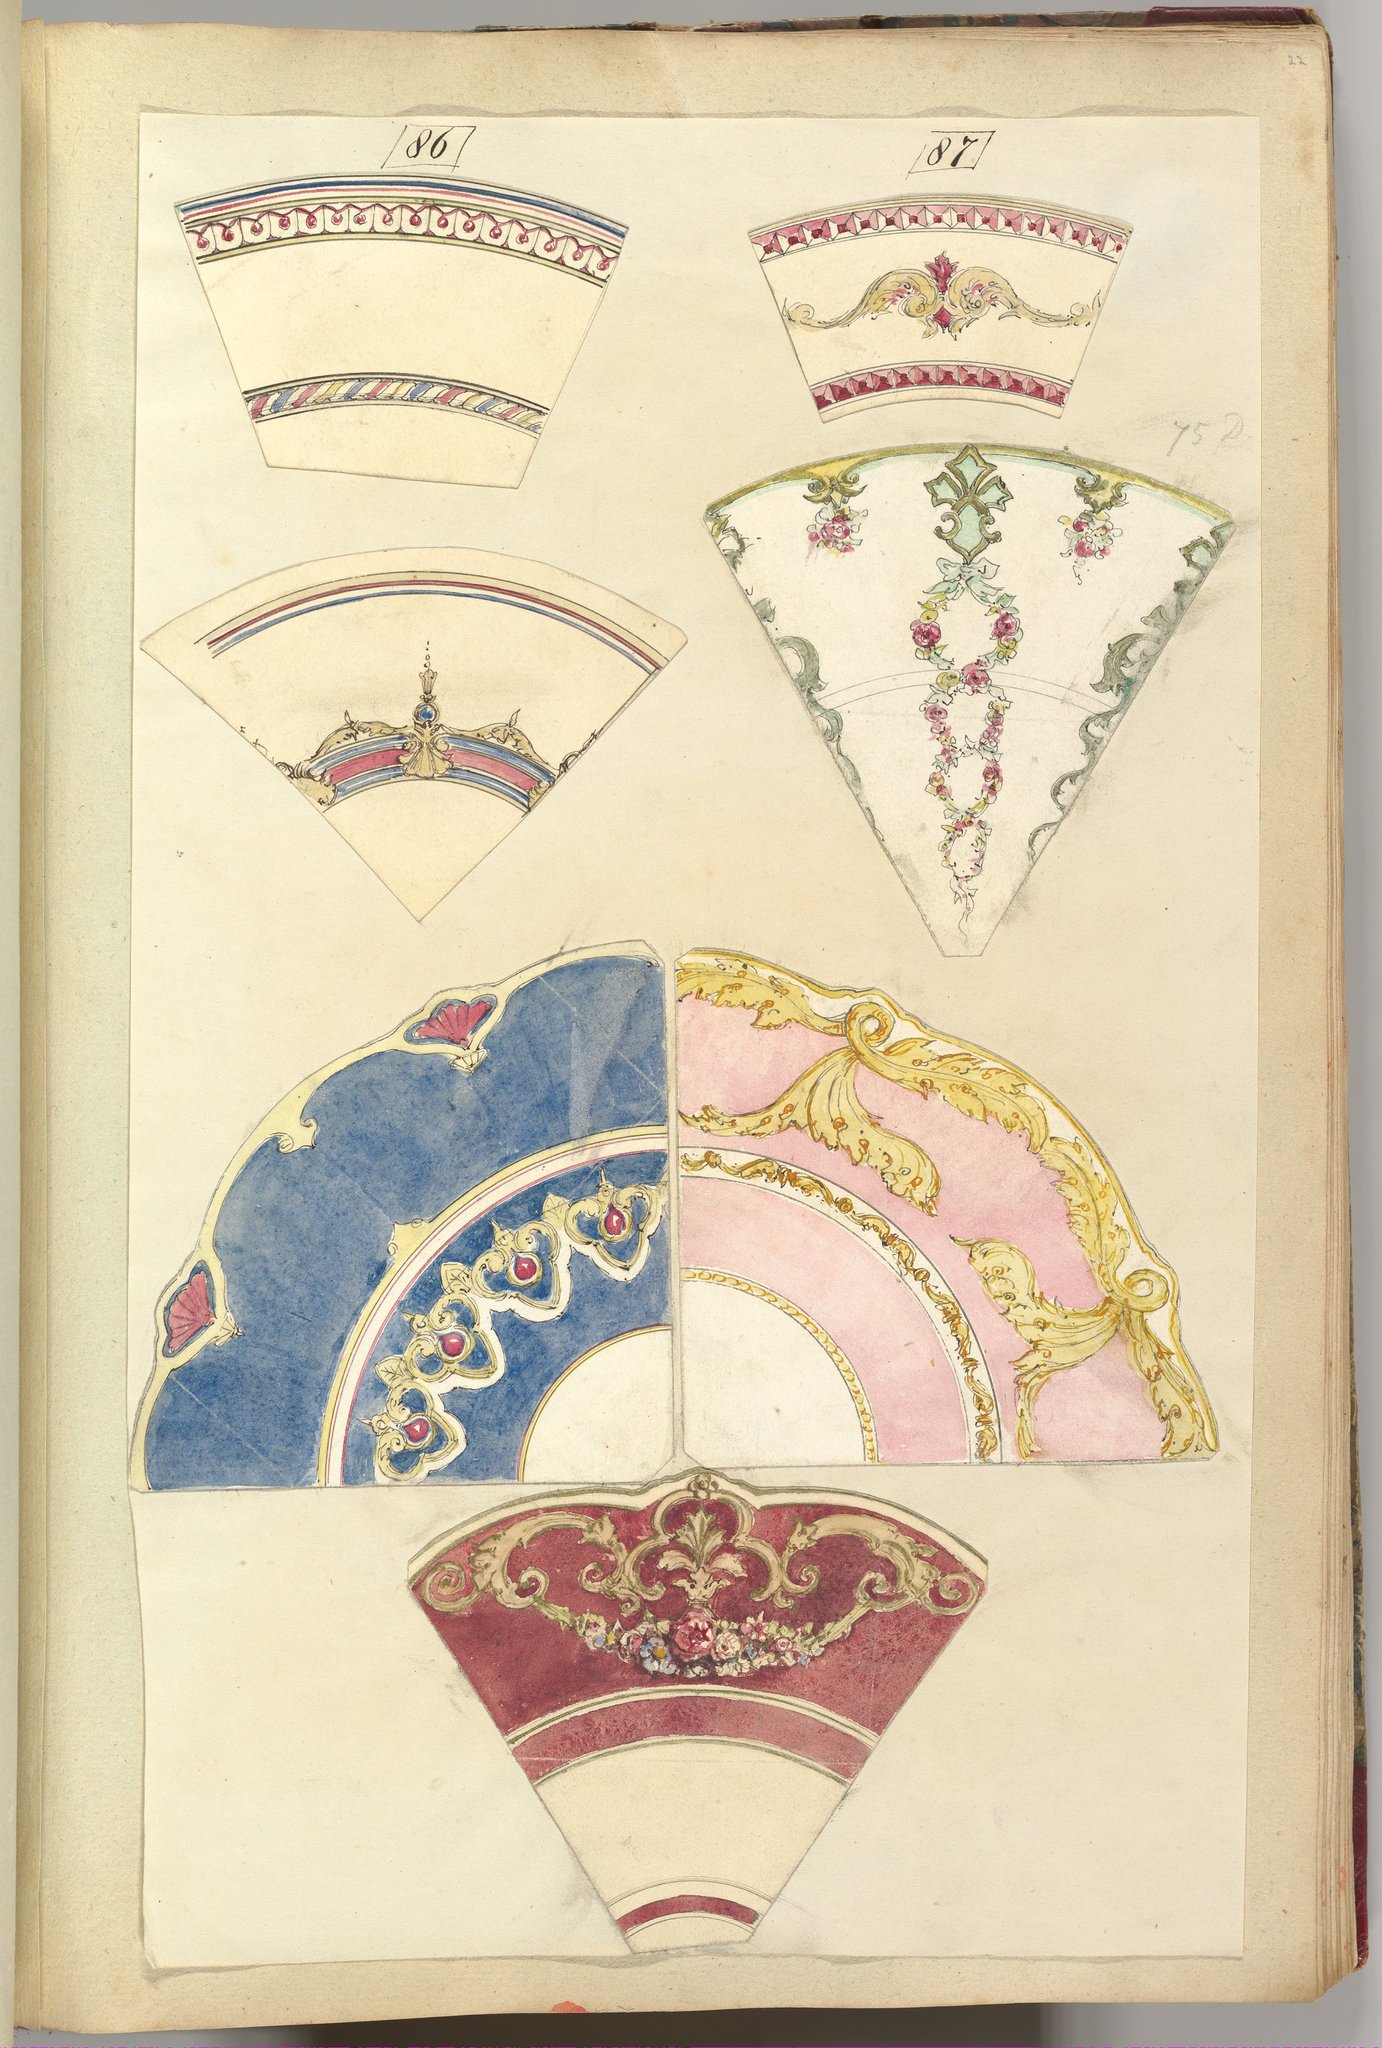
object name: drawing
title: Seven Designs for Decorated Plates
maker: alfred henry forrester [alfred crowquill]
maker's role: artist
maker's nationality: british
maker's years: 1804-1872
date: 1845-1855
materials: ink, watercolor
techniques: pen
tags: ornament